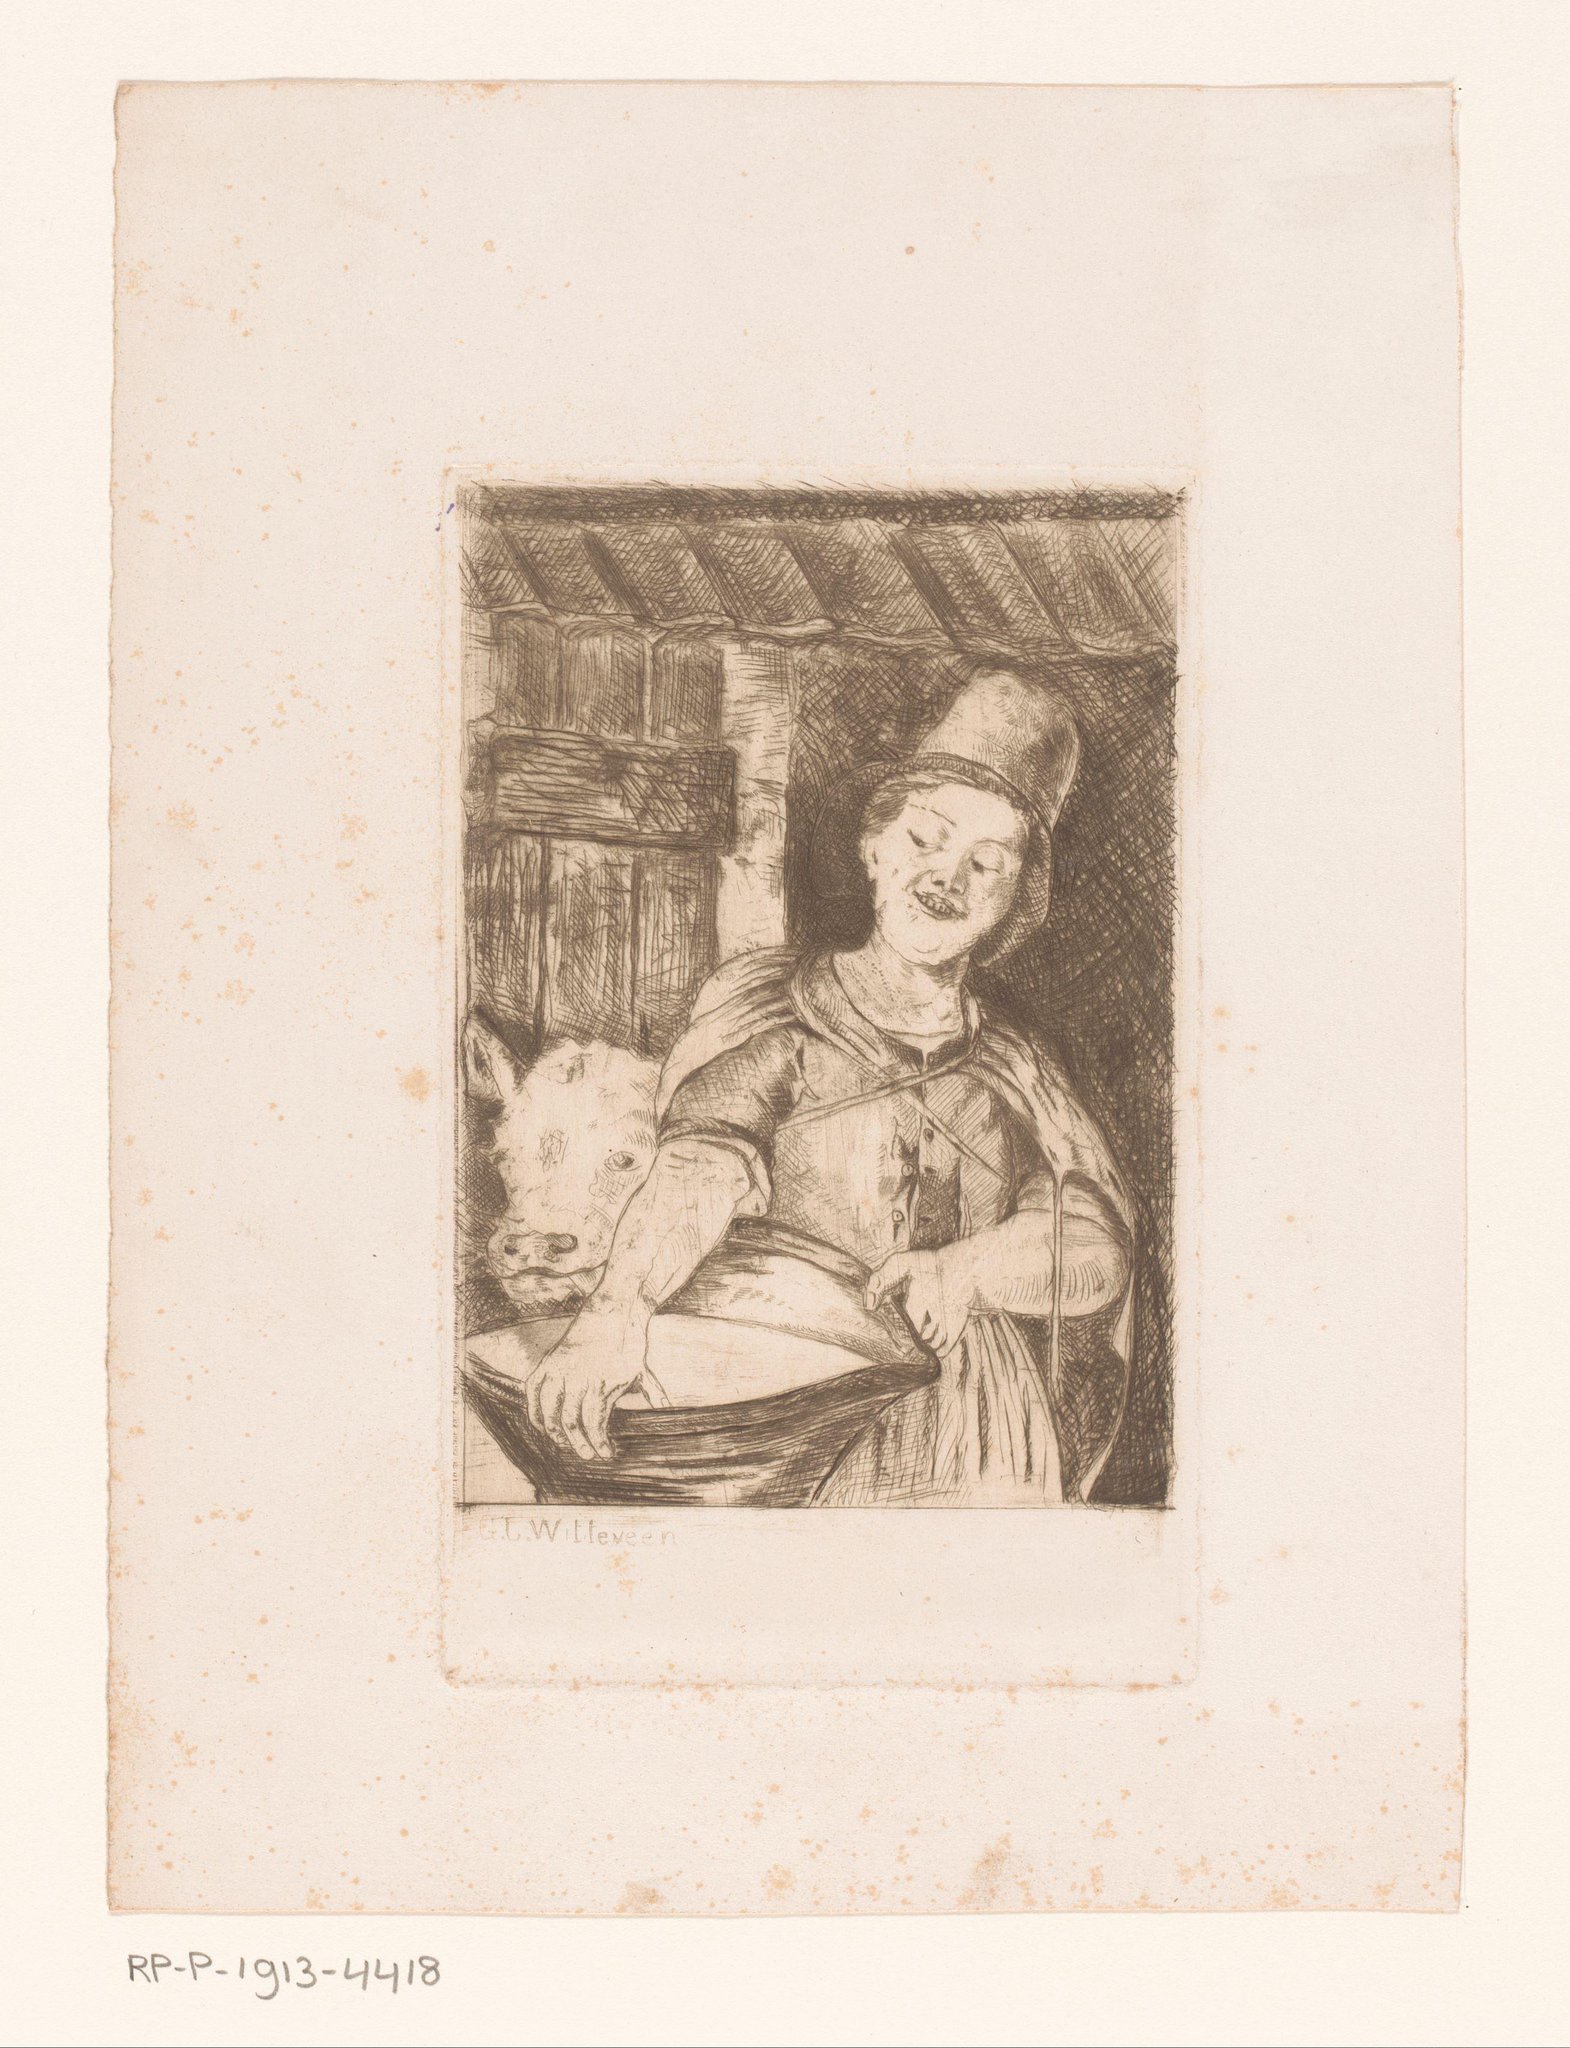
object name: print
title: Melkmeisje in koeienstal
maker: g.j. witteveen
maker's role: print maker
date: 1850-1913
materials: paper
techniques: drypoint, etching, retroussage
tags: cow, milkmaid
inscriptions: collector's mark: Lugt 2228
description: Sterfdatum van de prentmaker is onbekend. Daarom is voor de bepaling van de rechten van dit object gebruik gemaakt van de verwervingsdatum Rijksmuseum Amsterdam.